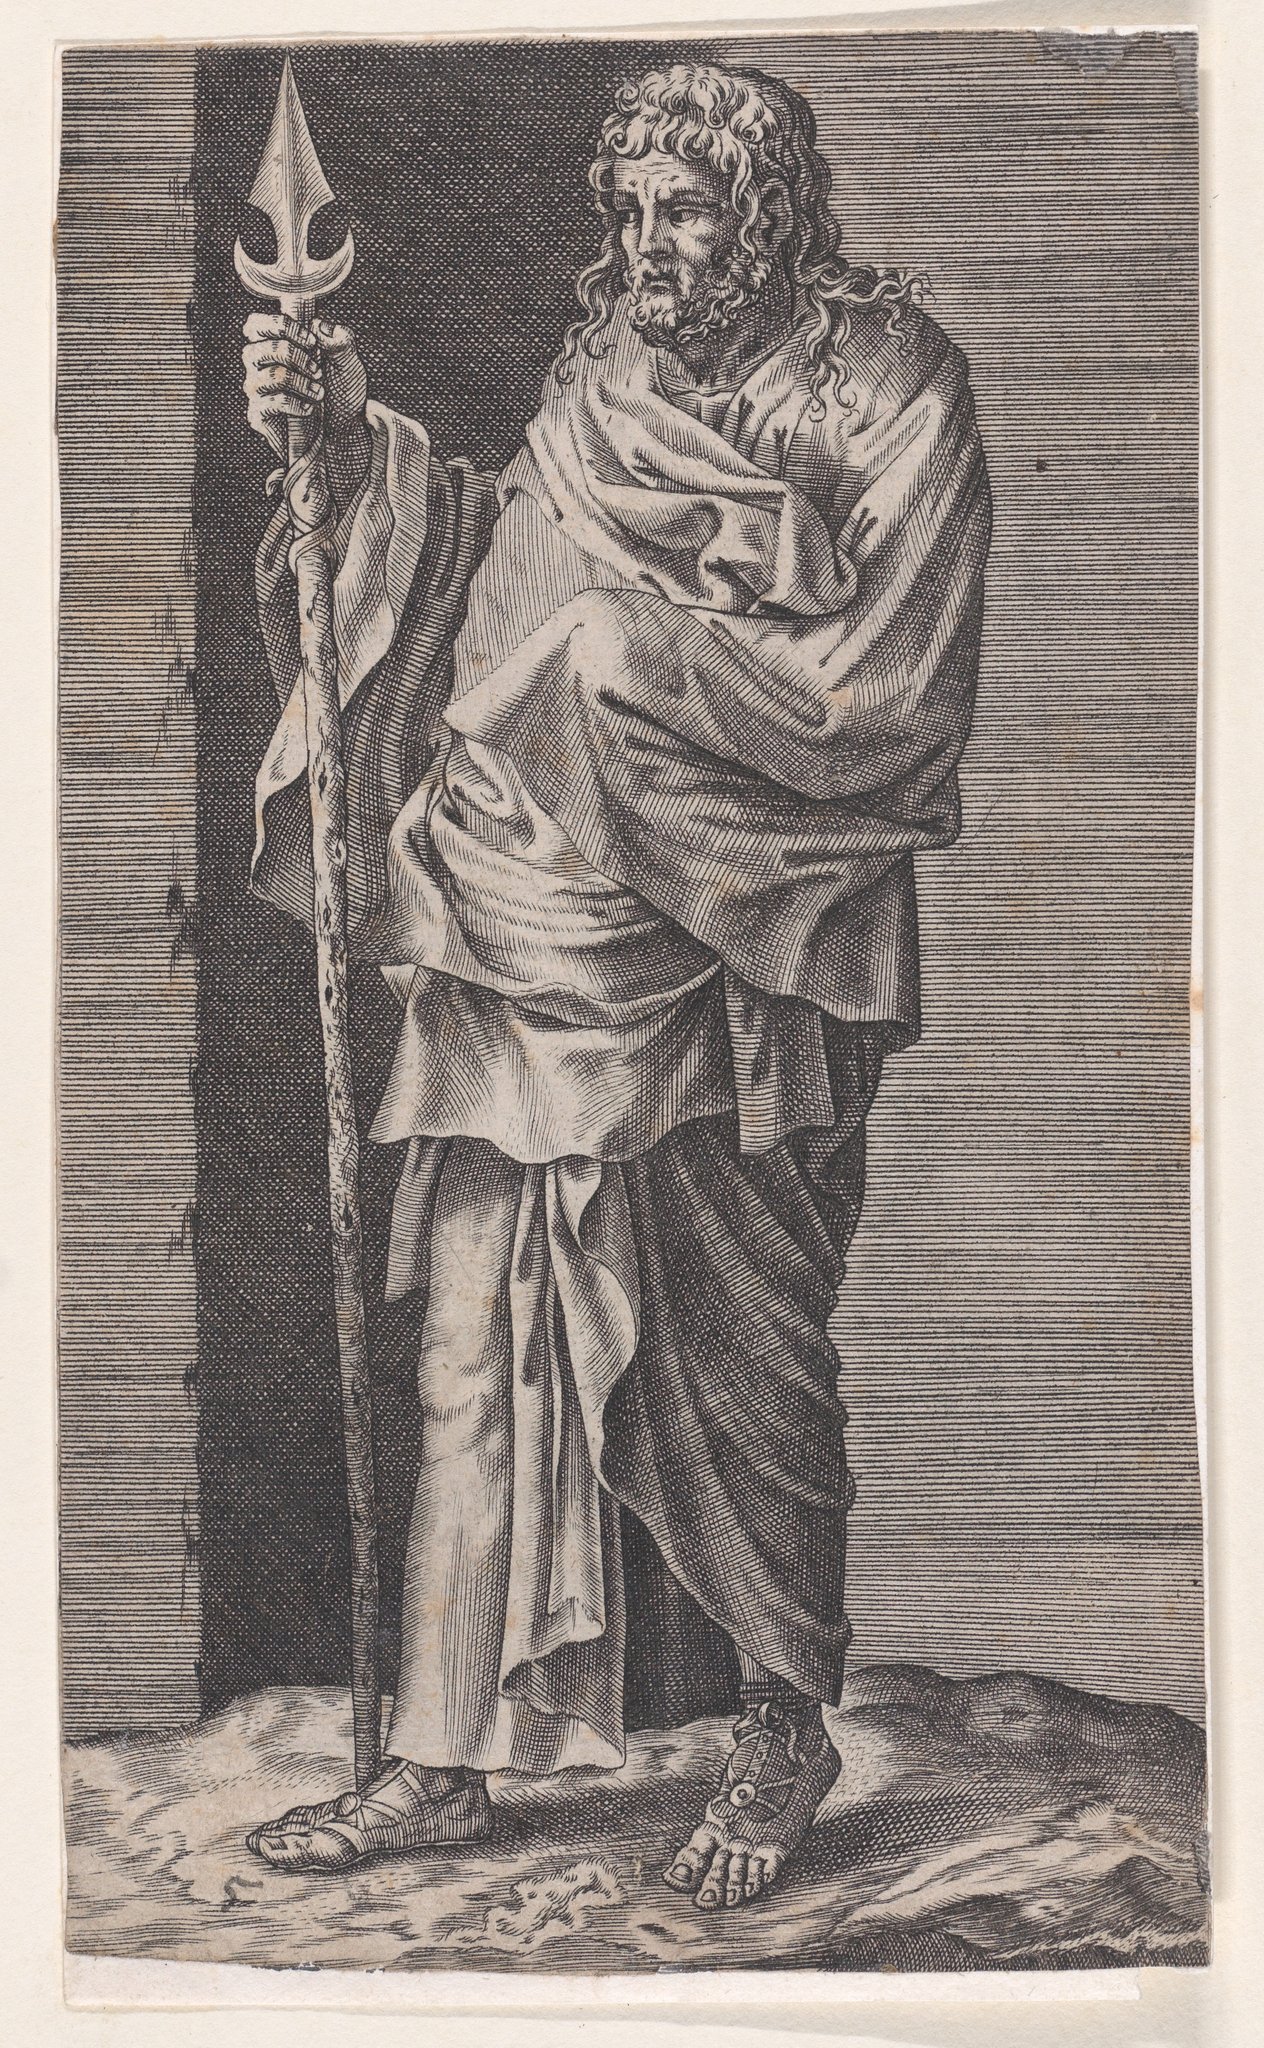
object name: print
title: St. Simon, from "Christ and the Apostles"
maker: lambert suavius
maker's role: artist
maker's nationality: netherlandish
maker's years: 1510-1576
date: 1530-1576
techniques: backing, engraving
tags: men,saints